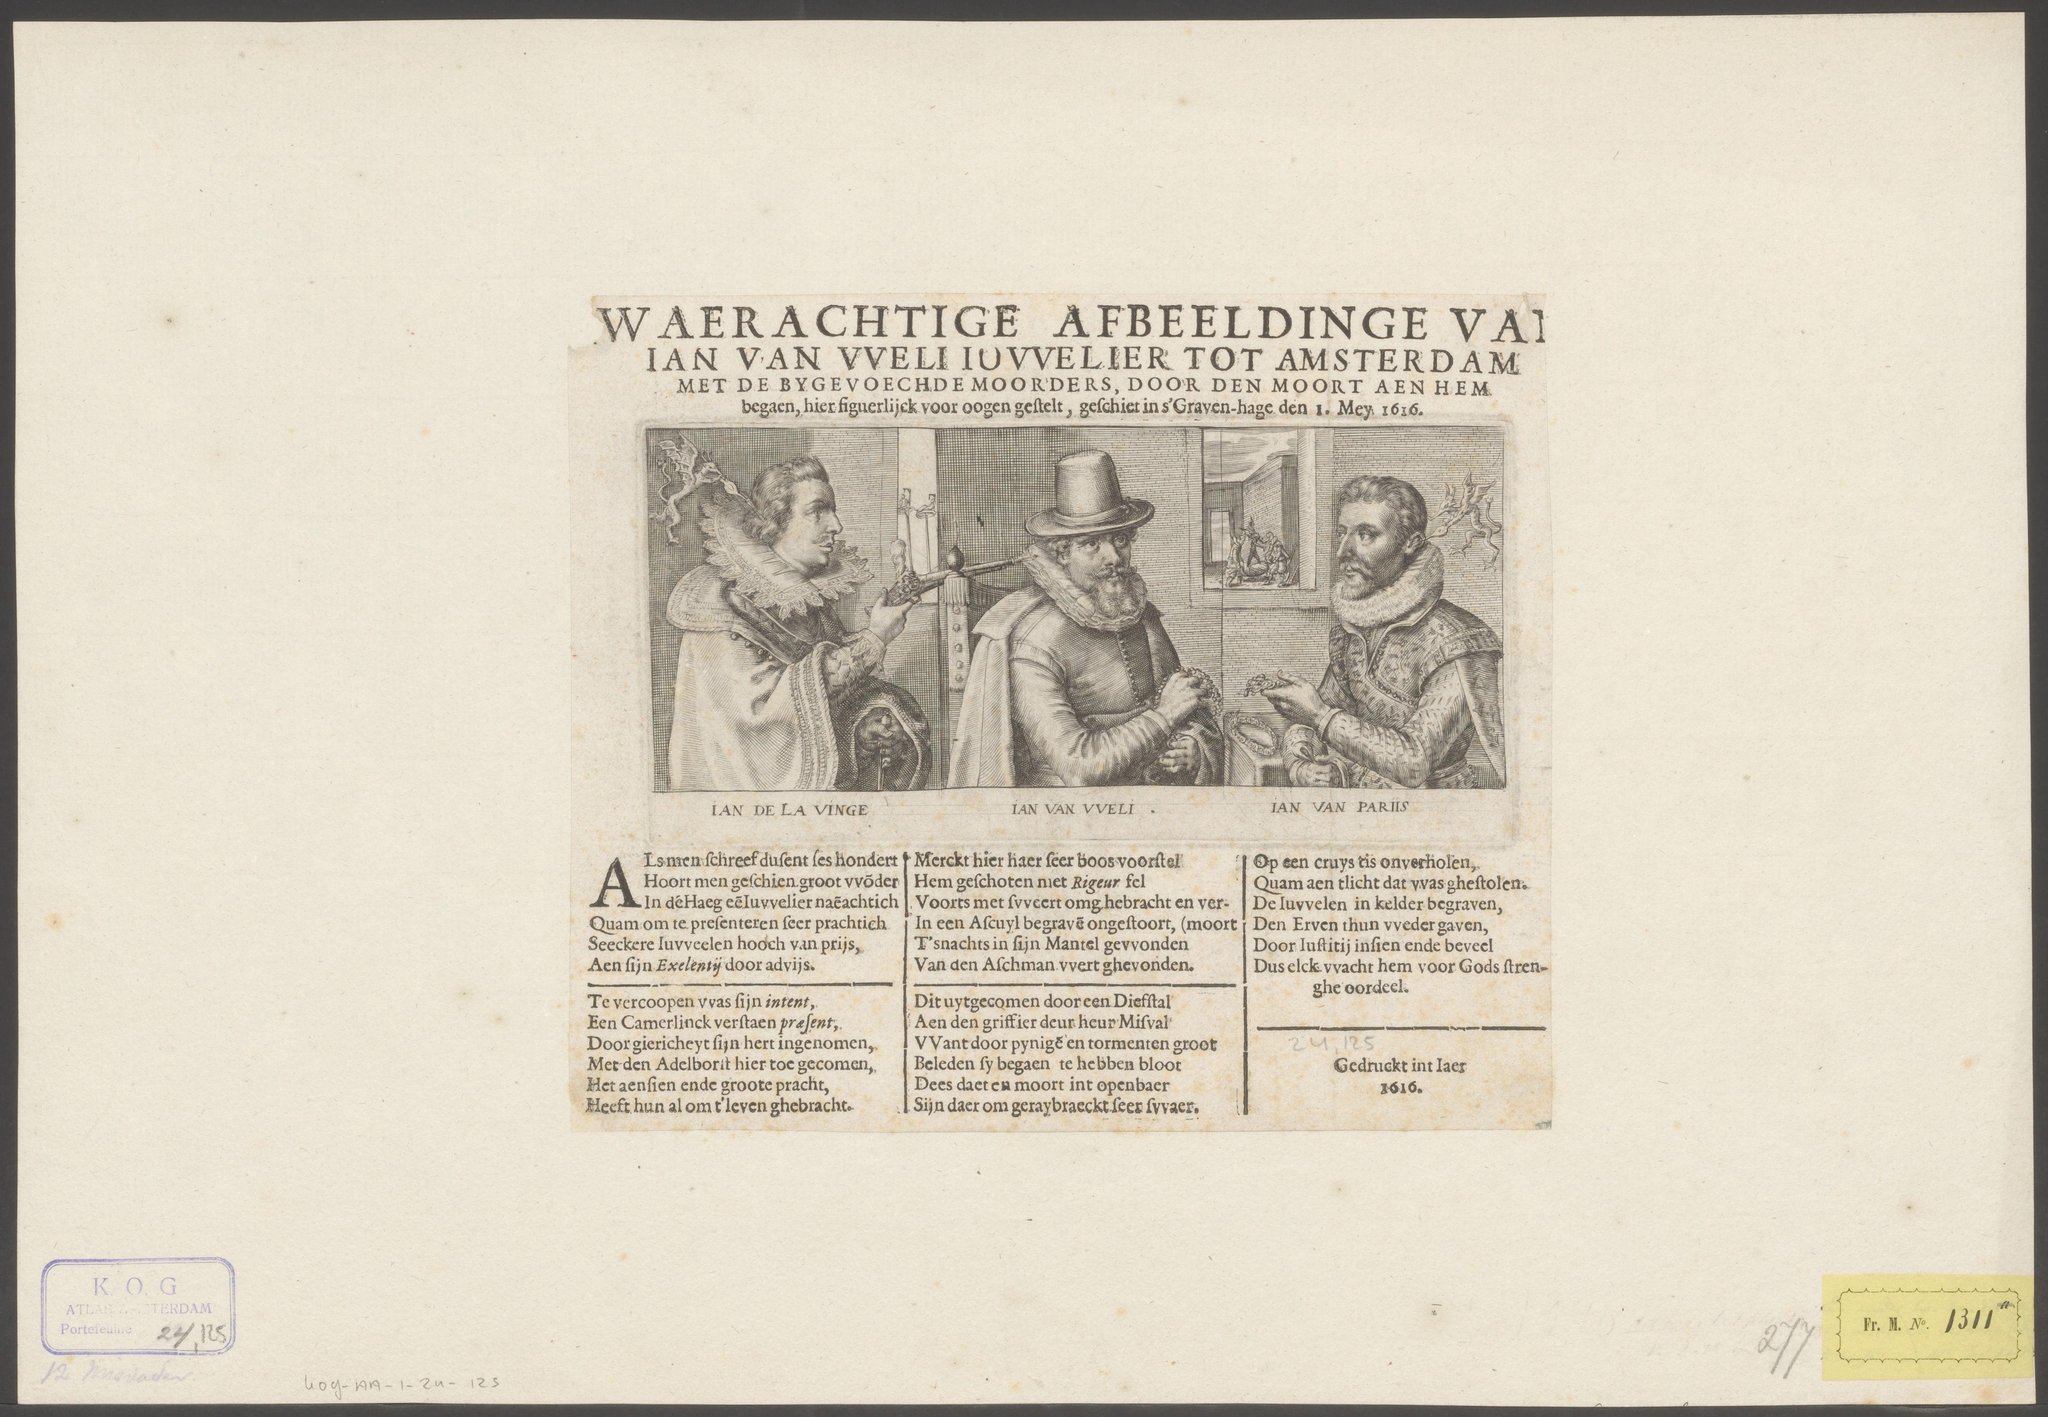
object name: print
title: Waerachtige afbeeldinge van Jan van Weli juwelier tot Amsterdam [...]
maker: crispijn van de passe (i)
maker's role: draughtsman, print maker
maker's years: 1564-1637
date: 1616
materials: paper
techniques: engraving, letterpress printing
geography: northern netherlands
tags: maurice (prince of orange), the hague, murder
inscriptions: collector's mark: Lugt 1641b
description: De roofmoord op de door Maurits ontboden Amsterdamse juwelier Jan van Wely in Den Haag op 1 mei 1616. De moord met links Jan de la Vigne en rechts Jan van Parijs. Beiden worden door een duiveltje met een blaasbalg bij hun oor aangezet tot de moord. Op de achtergrond het vinden van het lijk van de juwelier en de lichamen van de geradbraakte moordenaars tentoongesteld op staken. Gedrukt op een blad met bovenaan de titel en onderaan vijf verzen van zes regels in het Nederlands. Onderwerpsrubriek binnen de Atlas Amsterdam: Misdaden.